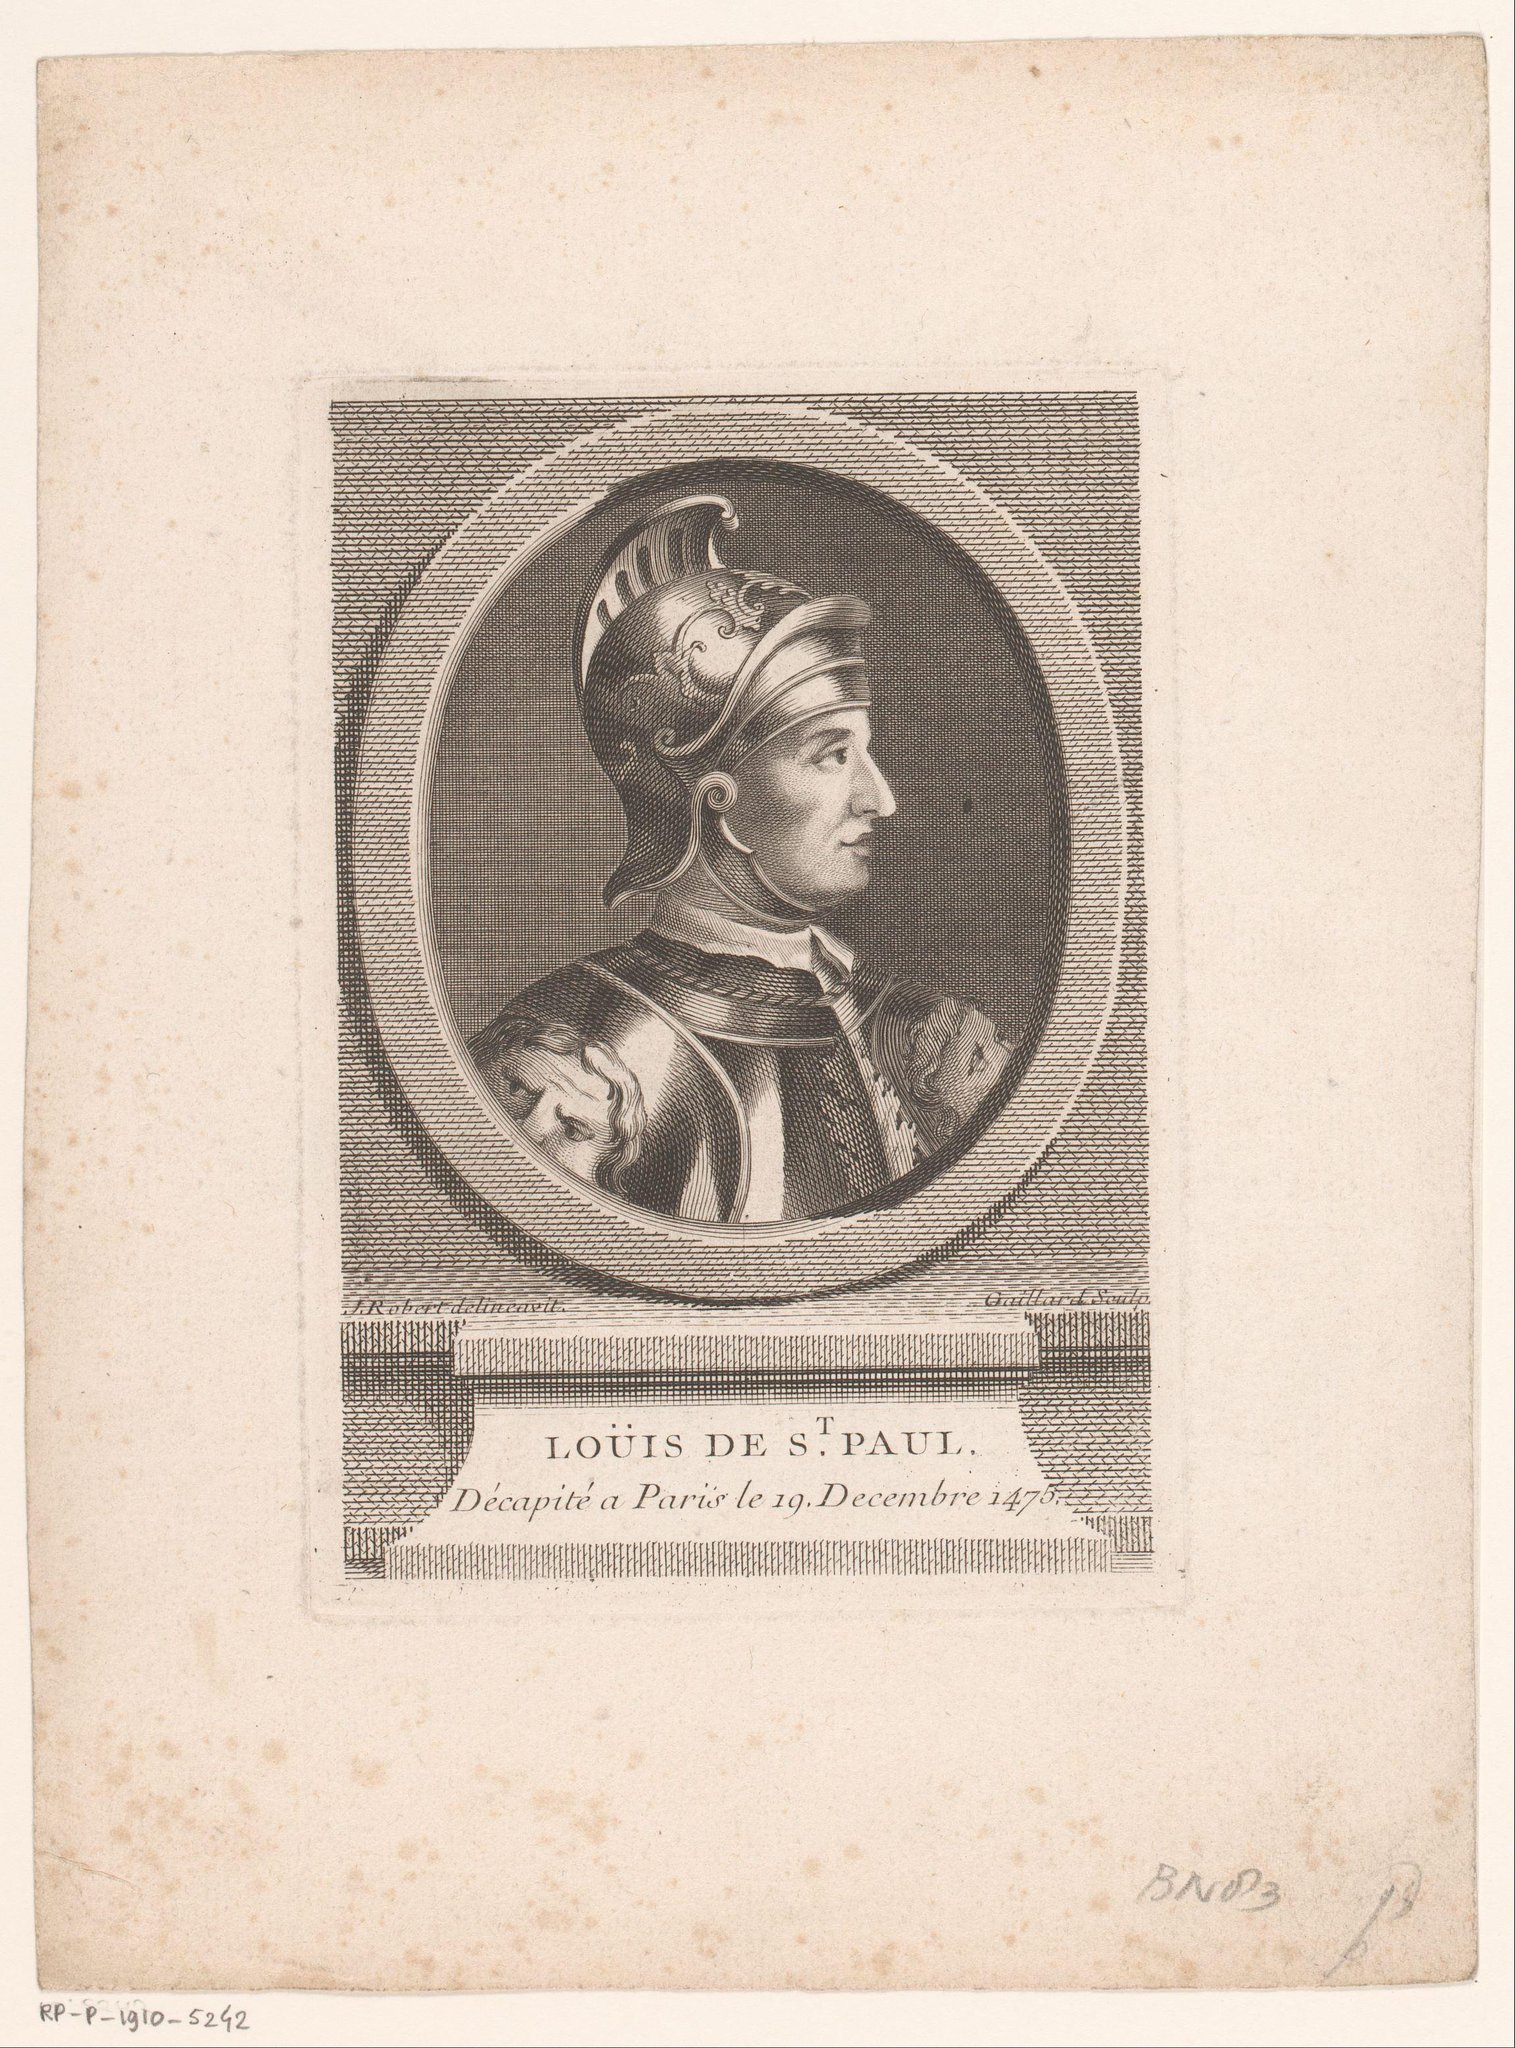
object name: print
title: Portret van Louis de Luxembourg-Saint-Pol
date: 1755-1765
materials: paper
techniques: engraving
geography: paris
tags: paris, historical persons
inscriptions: collector's mark: Lugt 2228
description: Mogelijk prent uit: Dreux du Radier, Jean-François. L'Europe illustré, contenant l'histoire abregée des souverains, des princes, des prélats, des ministres, (...) en Europe: dans le XVe. siècle compris, jusqu'à présent. Parijs: Michel Odieuvre en André-François Le Breton, 1755-1765, dl. 3.